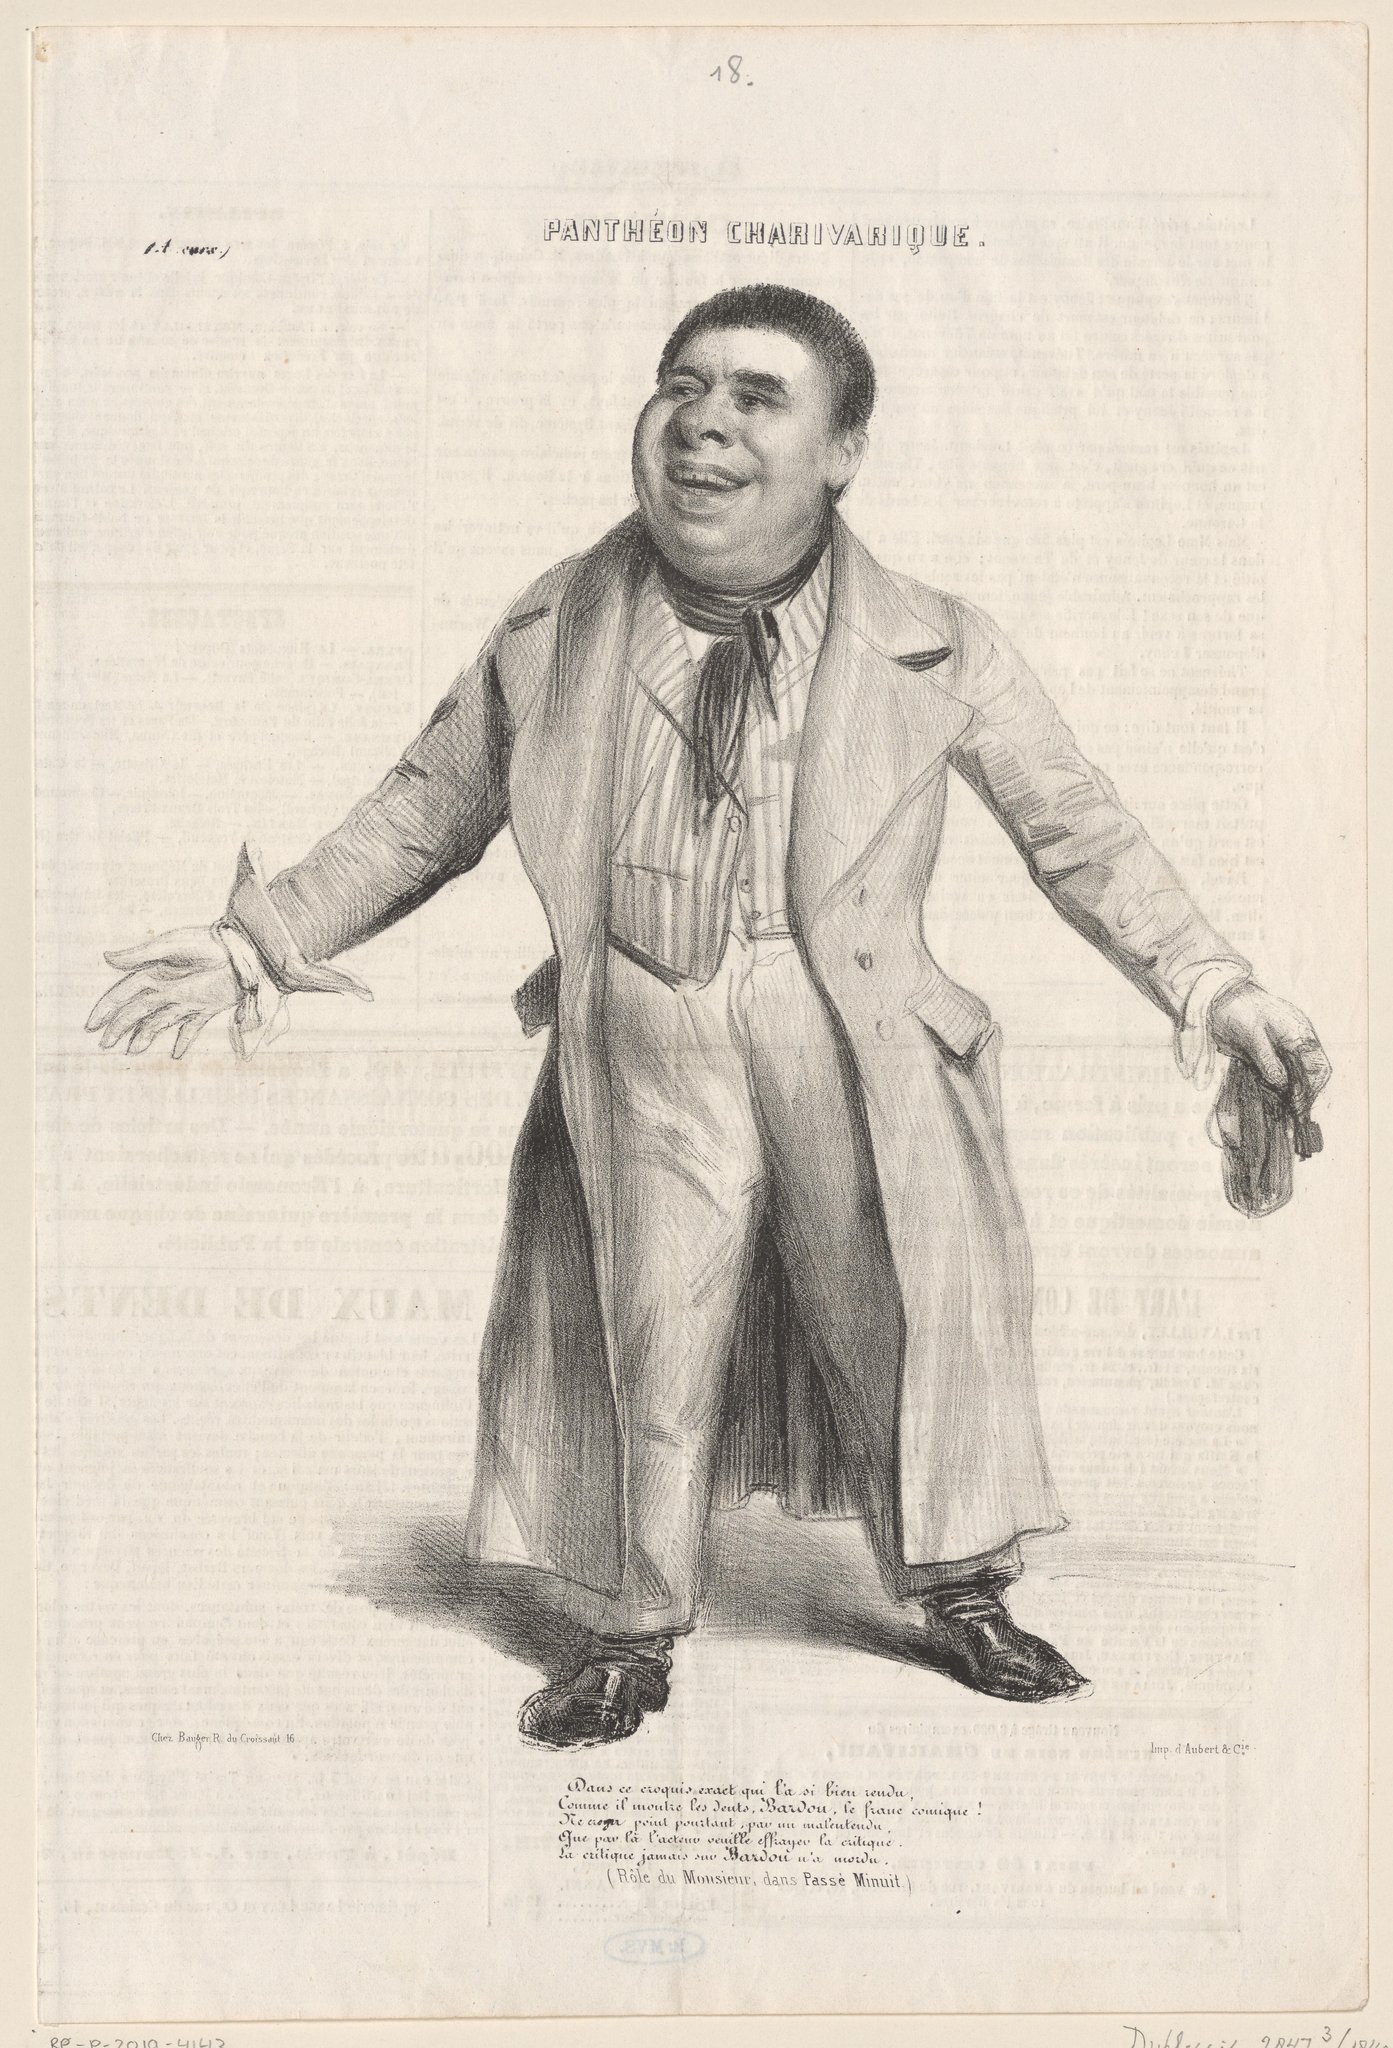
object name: print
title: Karikatuur van Oscar-François Bardou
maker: benjamin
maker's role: print maker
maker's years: 1811-1847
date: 1840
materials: paper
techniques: letterpress printing, lithograph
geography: paris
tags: historical persons, portrait of actor, actress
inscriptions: collector's mark: Lugt 2228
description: Prent uit: Le Charivari 9 (1840), nr. 242, 28 augustus 1840.